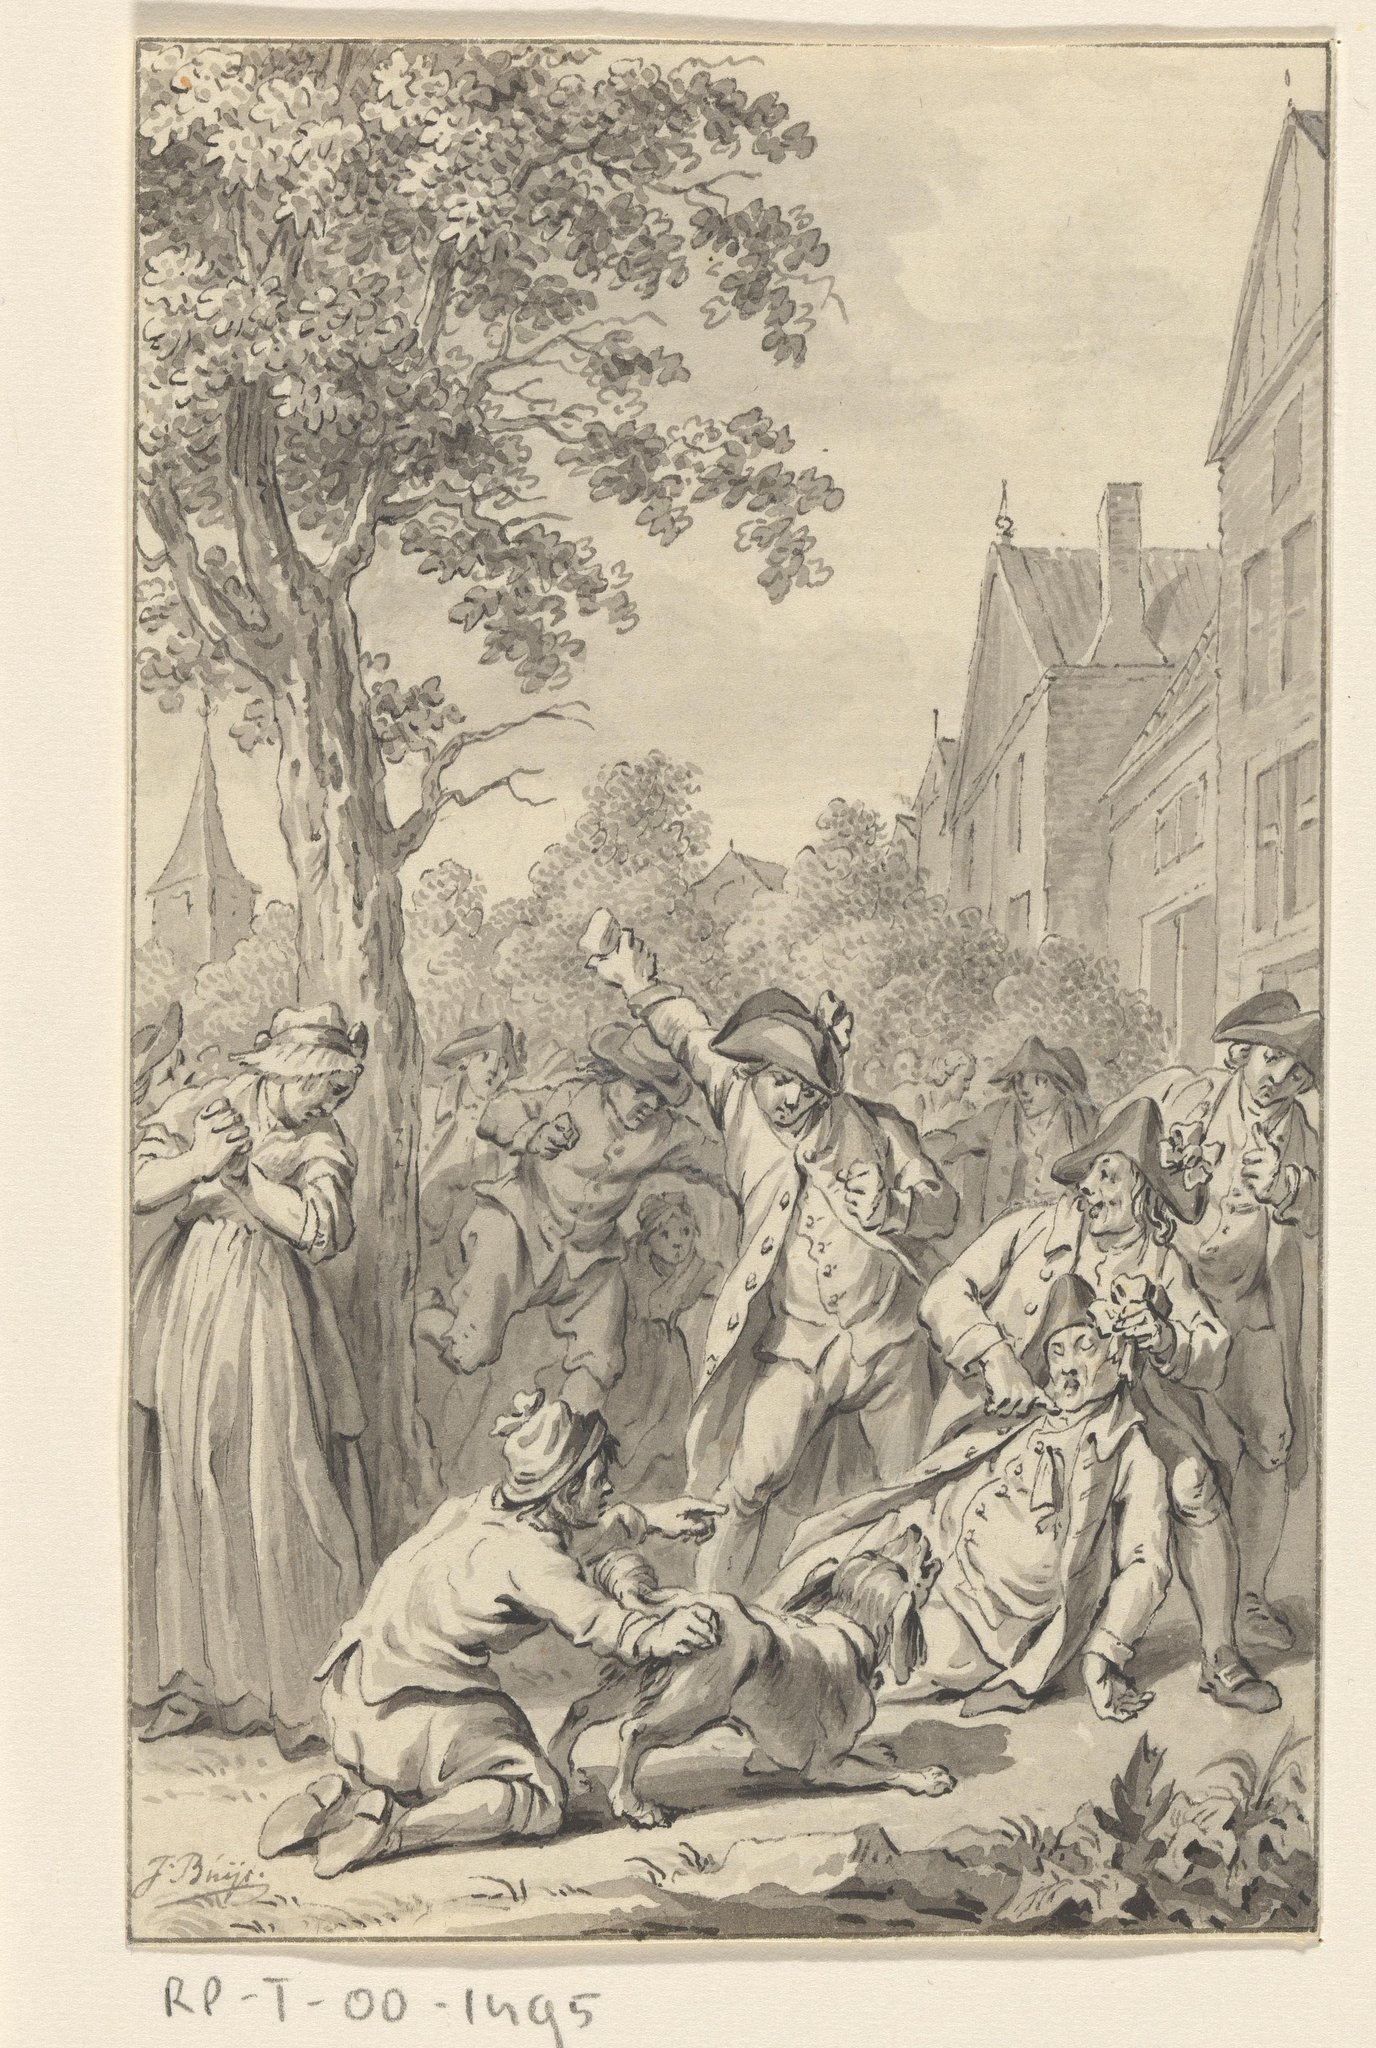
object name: drawing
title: Het lijk van de Leidse patriot, emeritus remonstrantse predikant P. van den Bosch te Zoetermeer mishandeld, november 1787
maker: jacobus buys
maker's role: draughtsman, print maker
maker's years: 1724-1801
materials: ink, paper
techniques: brush, pen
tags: historical persons, the corpse, street-fights, riots, historical events and situations